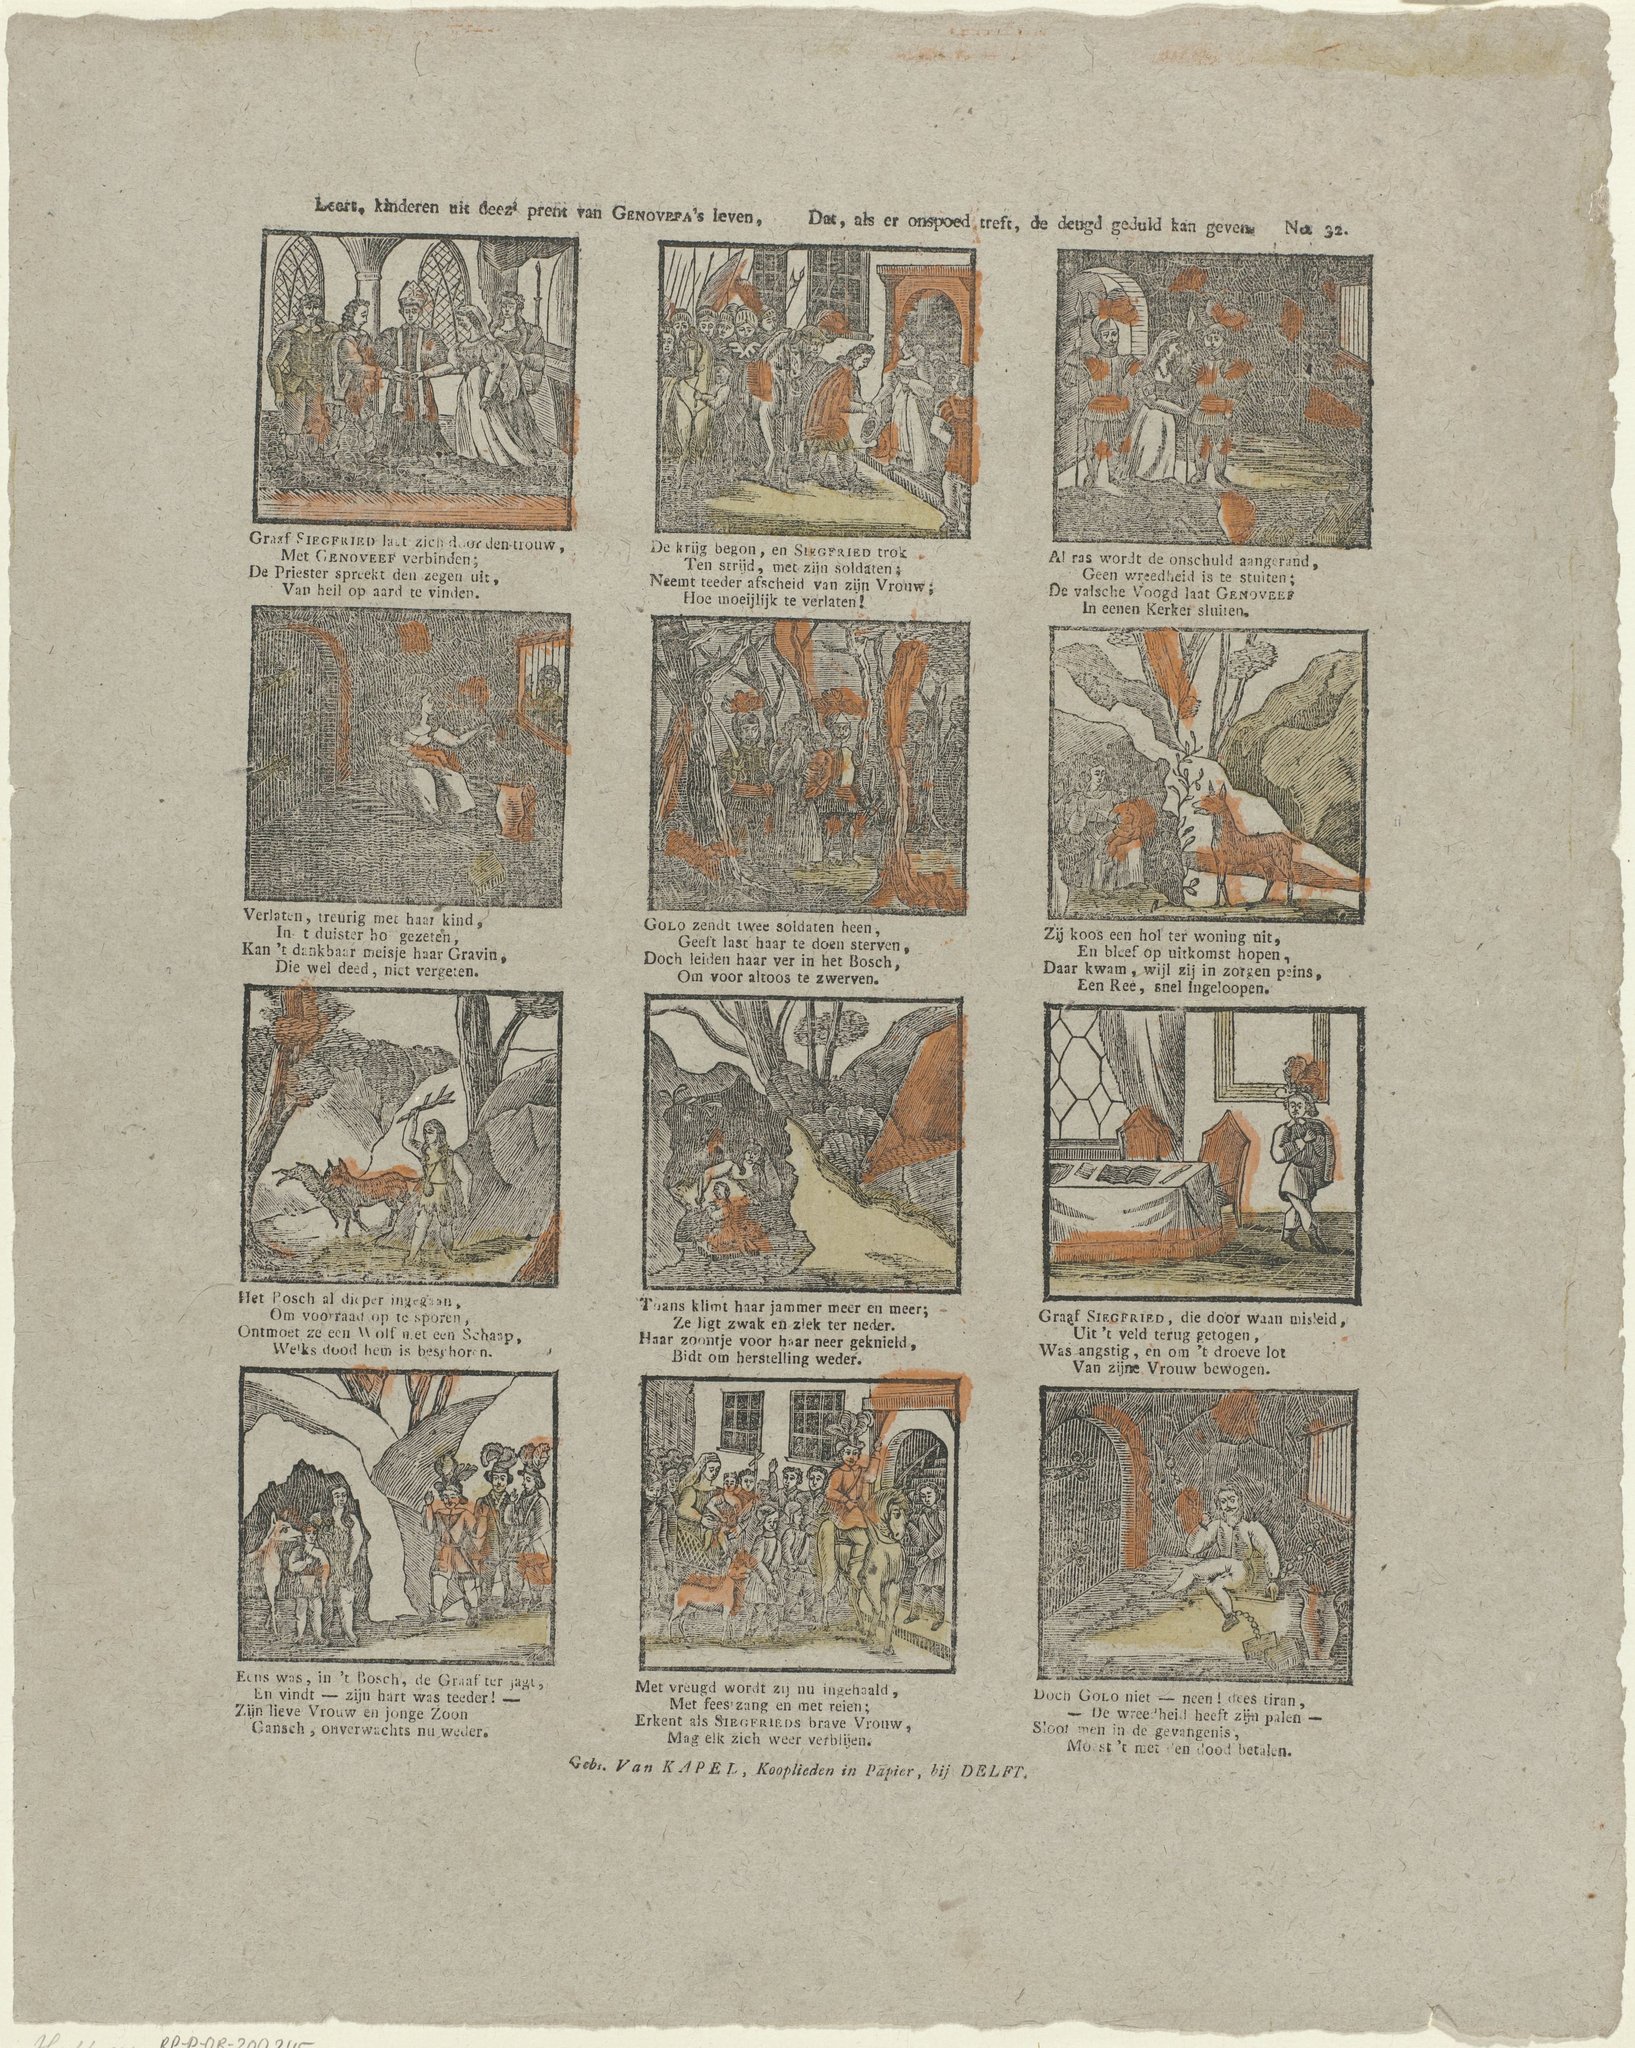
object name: print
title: Leert, kinderen uit deez' prent van Genovefa's leven, / Dat, als er onspoed treft, de deugd geduld kan geven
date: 1820-1837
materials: paper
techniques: colour, letterpress printing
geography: netherlands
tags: genoveva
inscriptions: collector's mark: Lugt 2760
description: Blad met 12 voorstellingen over het leven van Genoveva van Brabant. Onder elke voorstelling een vierregelig vers. Genummerd rechtsboven: No. 32.